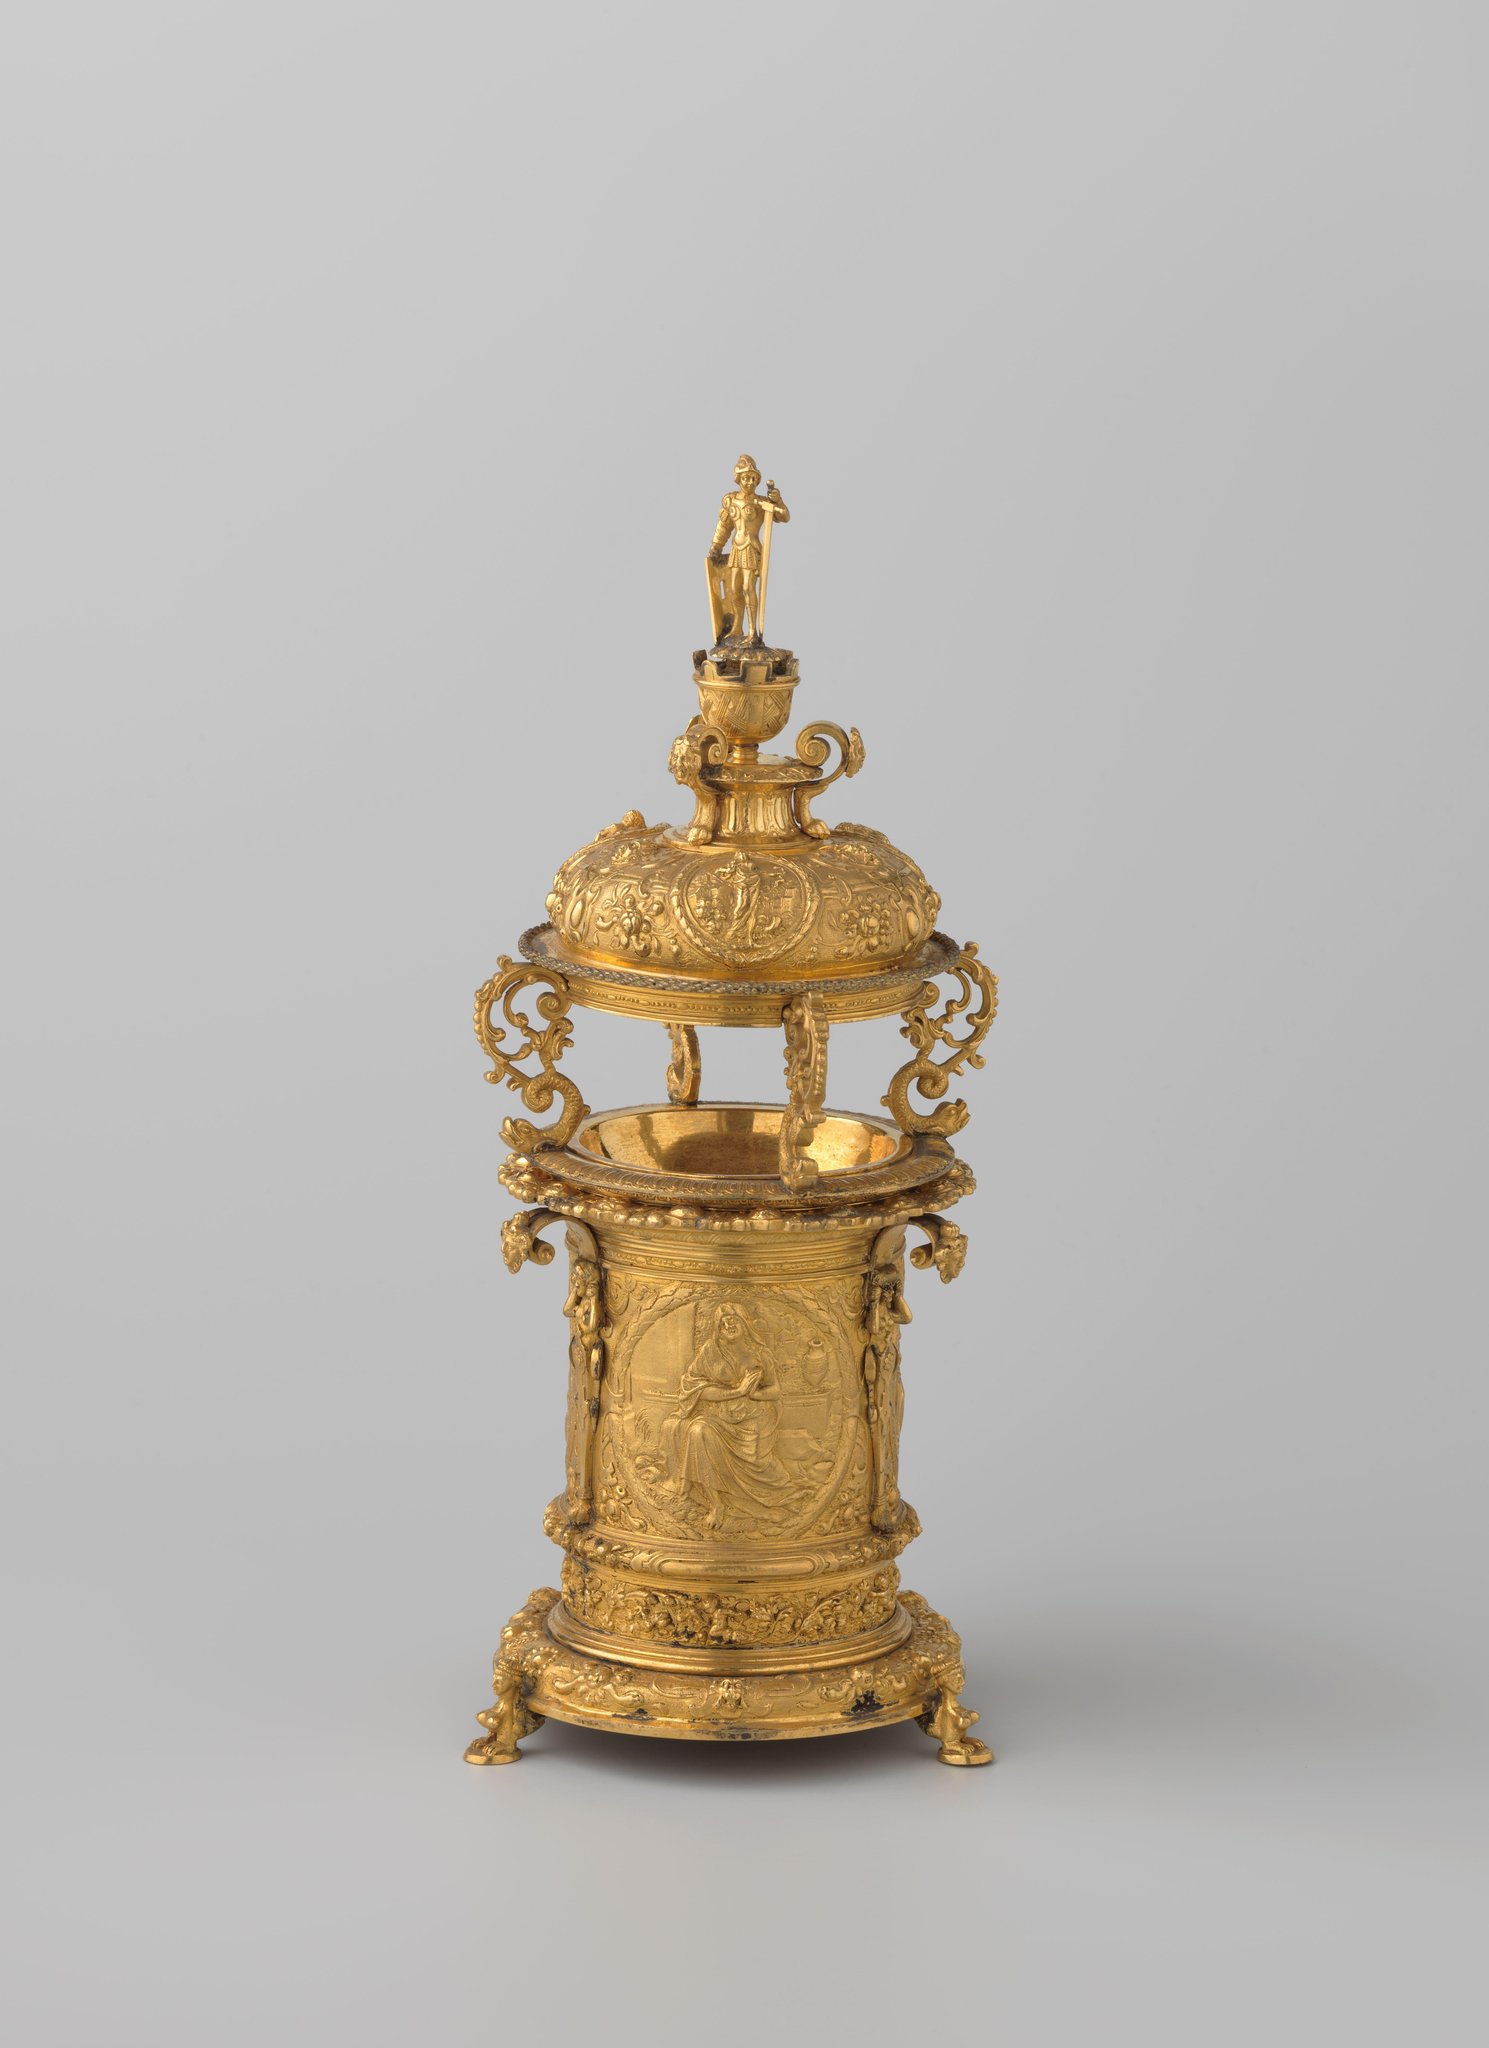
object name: salt condiment vessel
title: Galvanoplastische reproductie van een zoutvat met statuette van een krijgsman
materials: copper, silver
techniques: gilding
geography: london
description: Galvanoplastische reproductie van een zoutvat op piedestal; op het bovendeel een statuette van een krijgsman. Verguld.